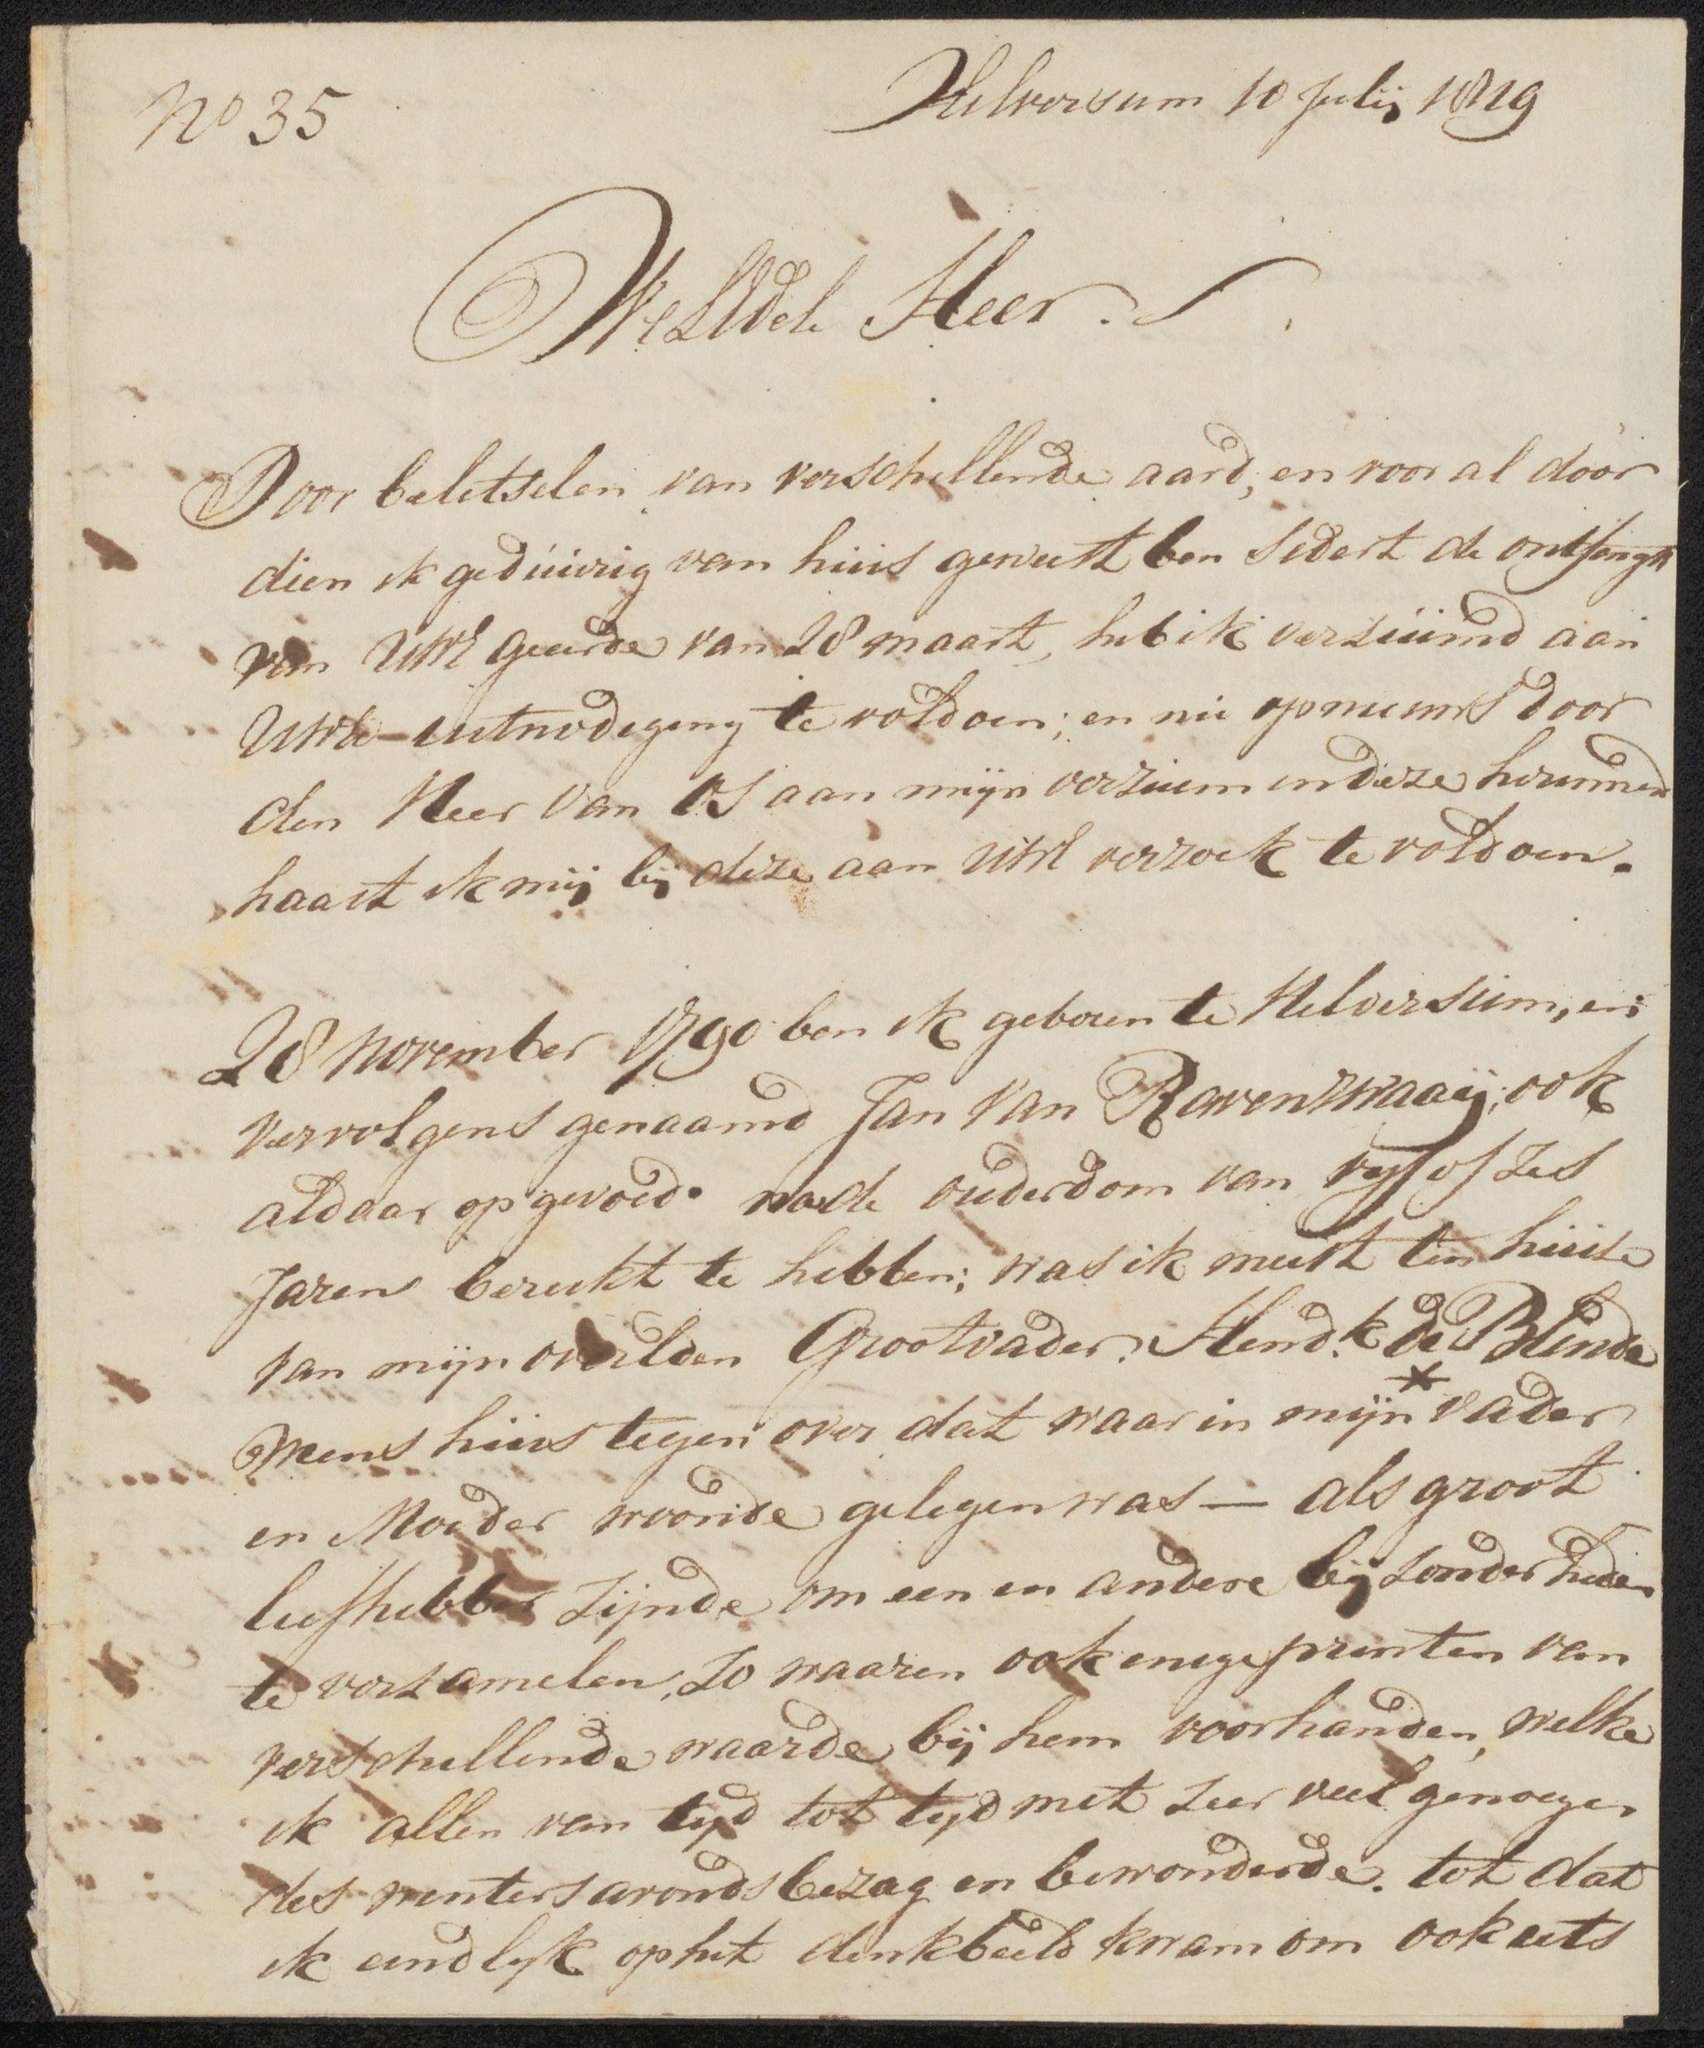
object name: letter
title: Brief aan Adriaan van der Willigen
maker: jan van ravenswaay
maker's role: draughtsman, painter, print maker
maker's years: 1789-1869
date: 1819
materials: ink, paper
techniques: pen, writing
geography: hilversum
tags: the hague, painter, print maker, draughtsman, pieter gerardus van os, rotterdam, adriaan van der willigen, painting (including book-illumination, miniature-painting), amsterdam